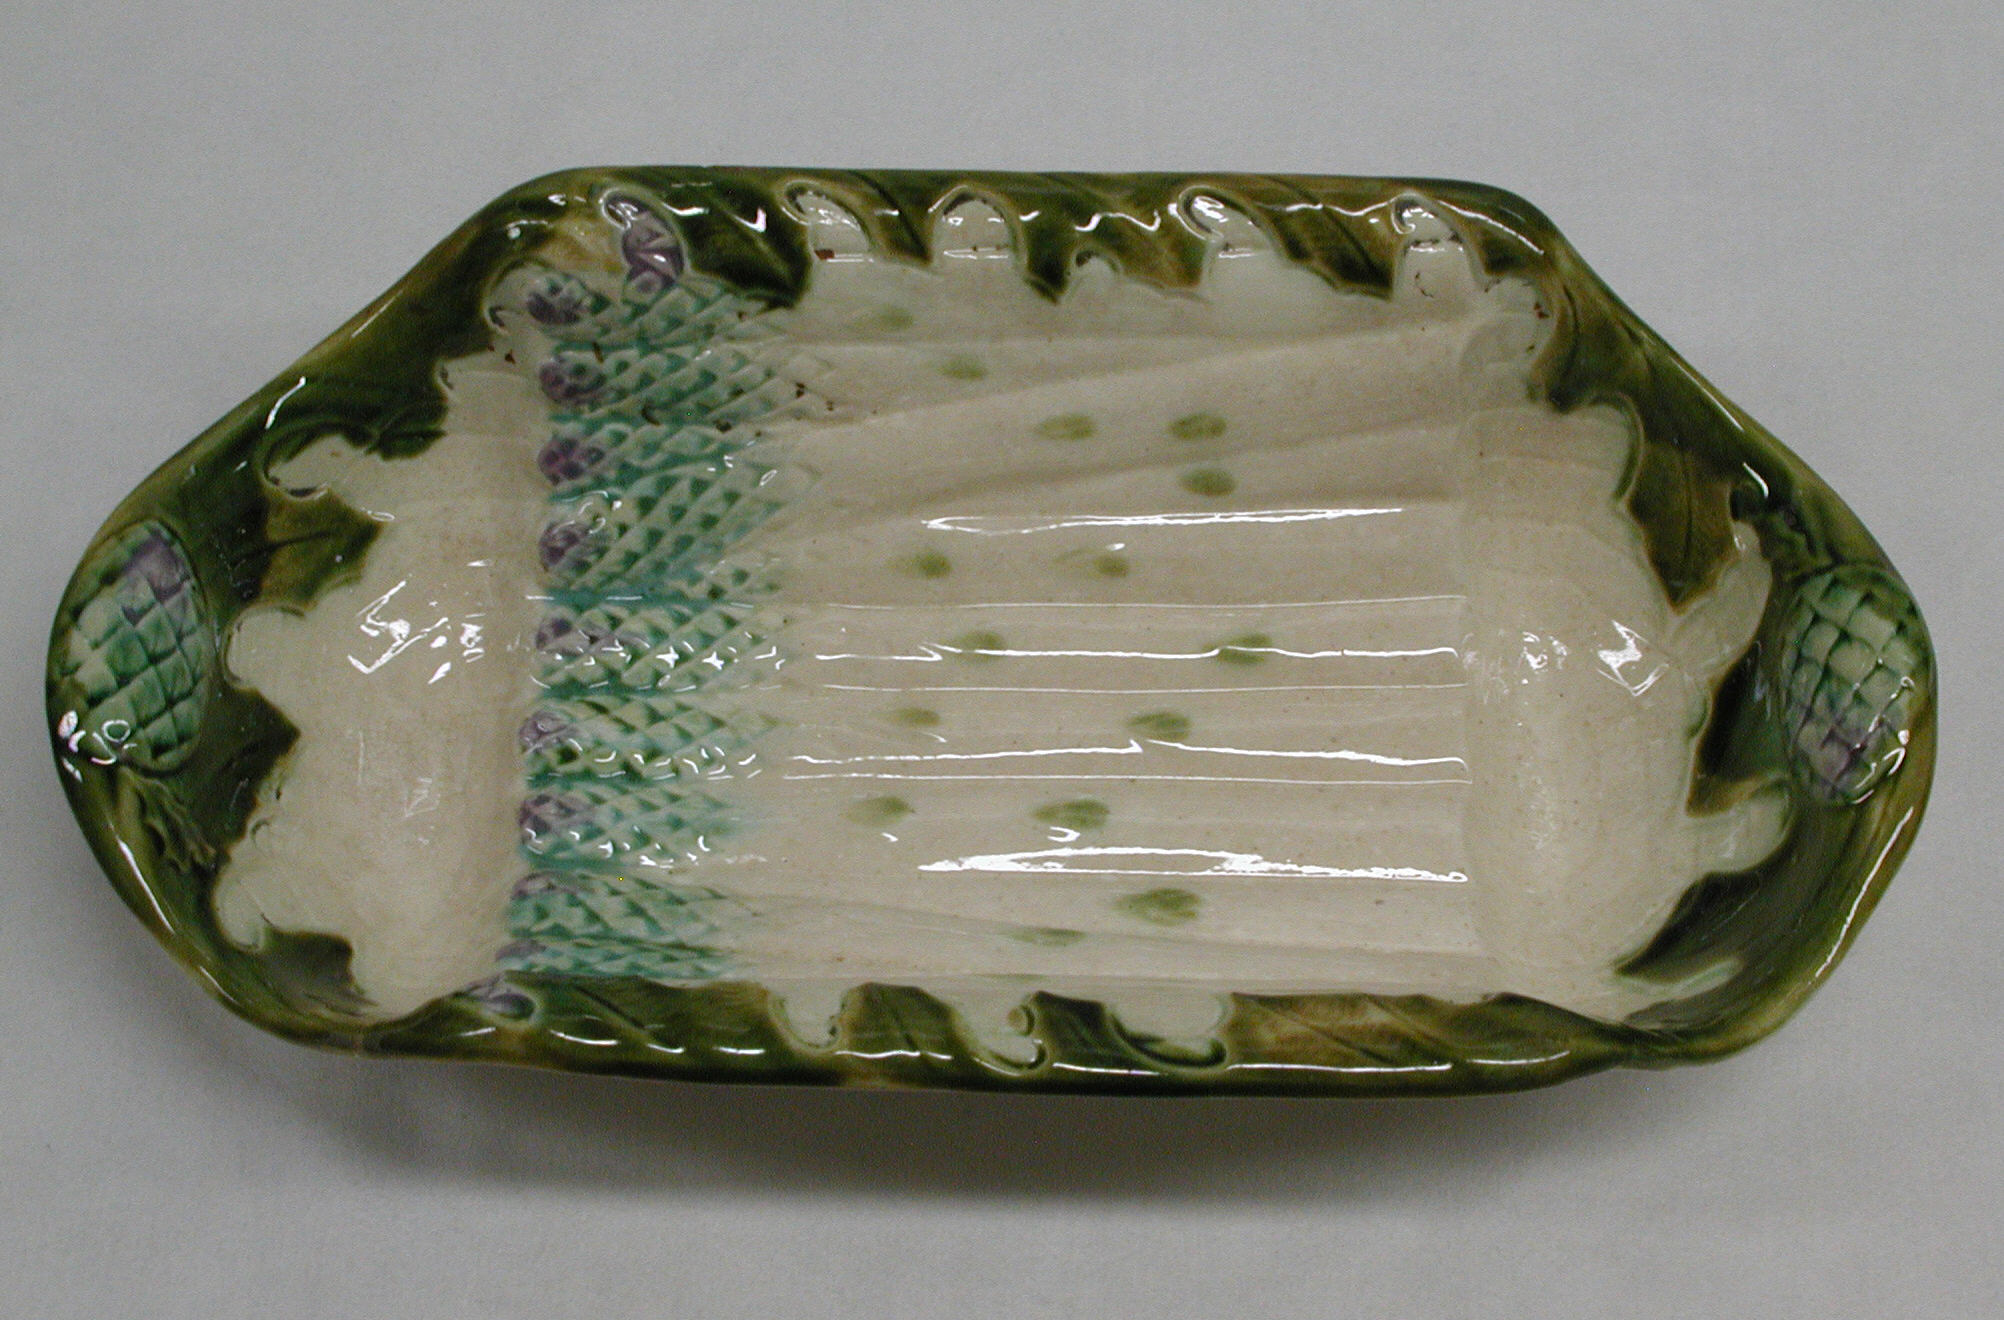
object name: asparagus dish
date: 1880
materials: creamware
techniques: glazing